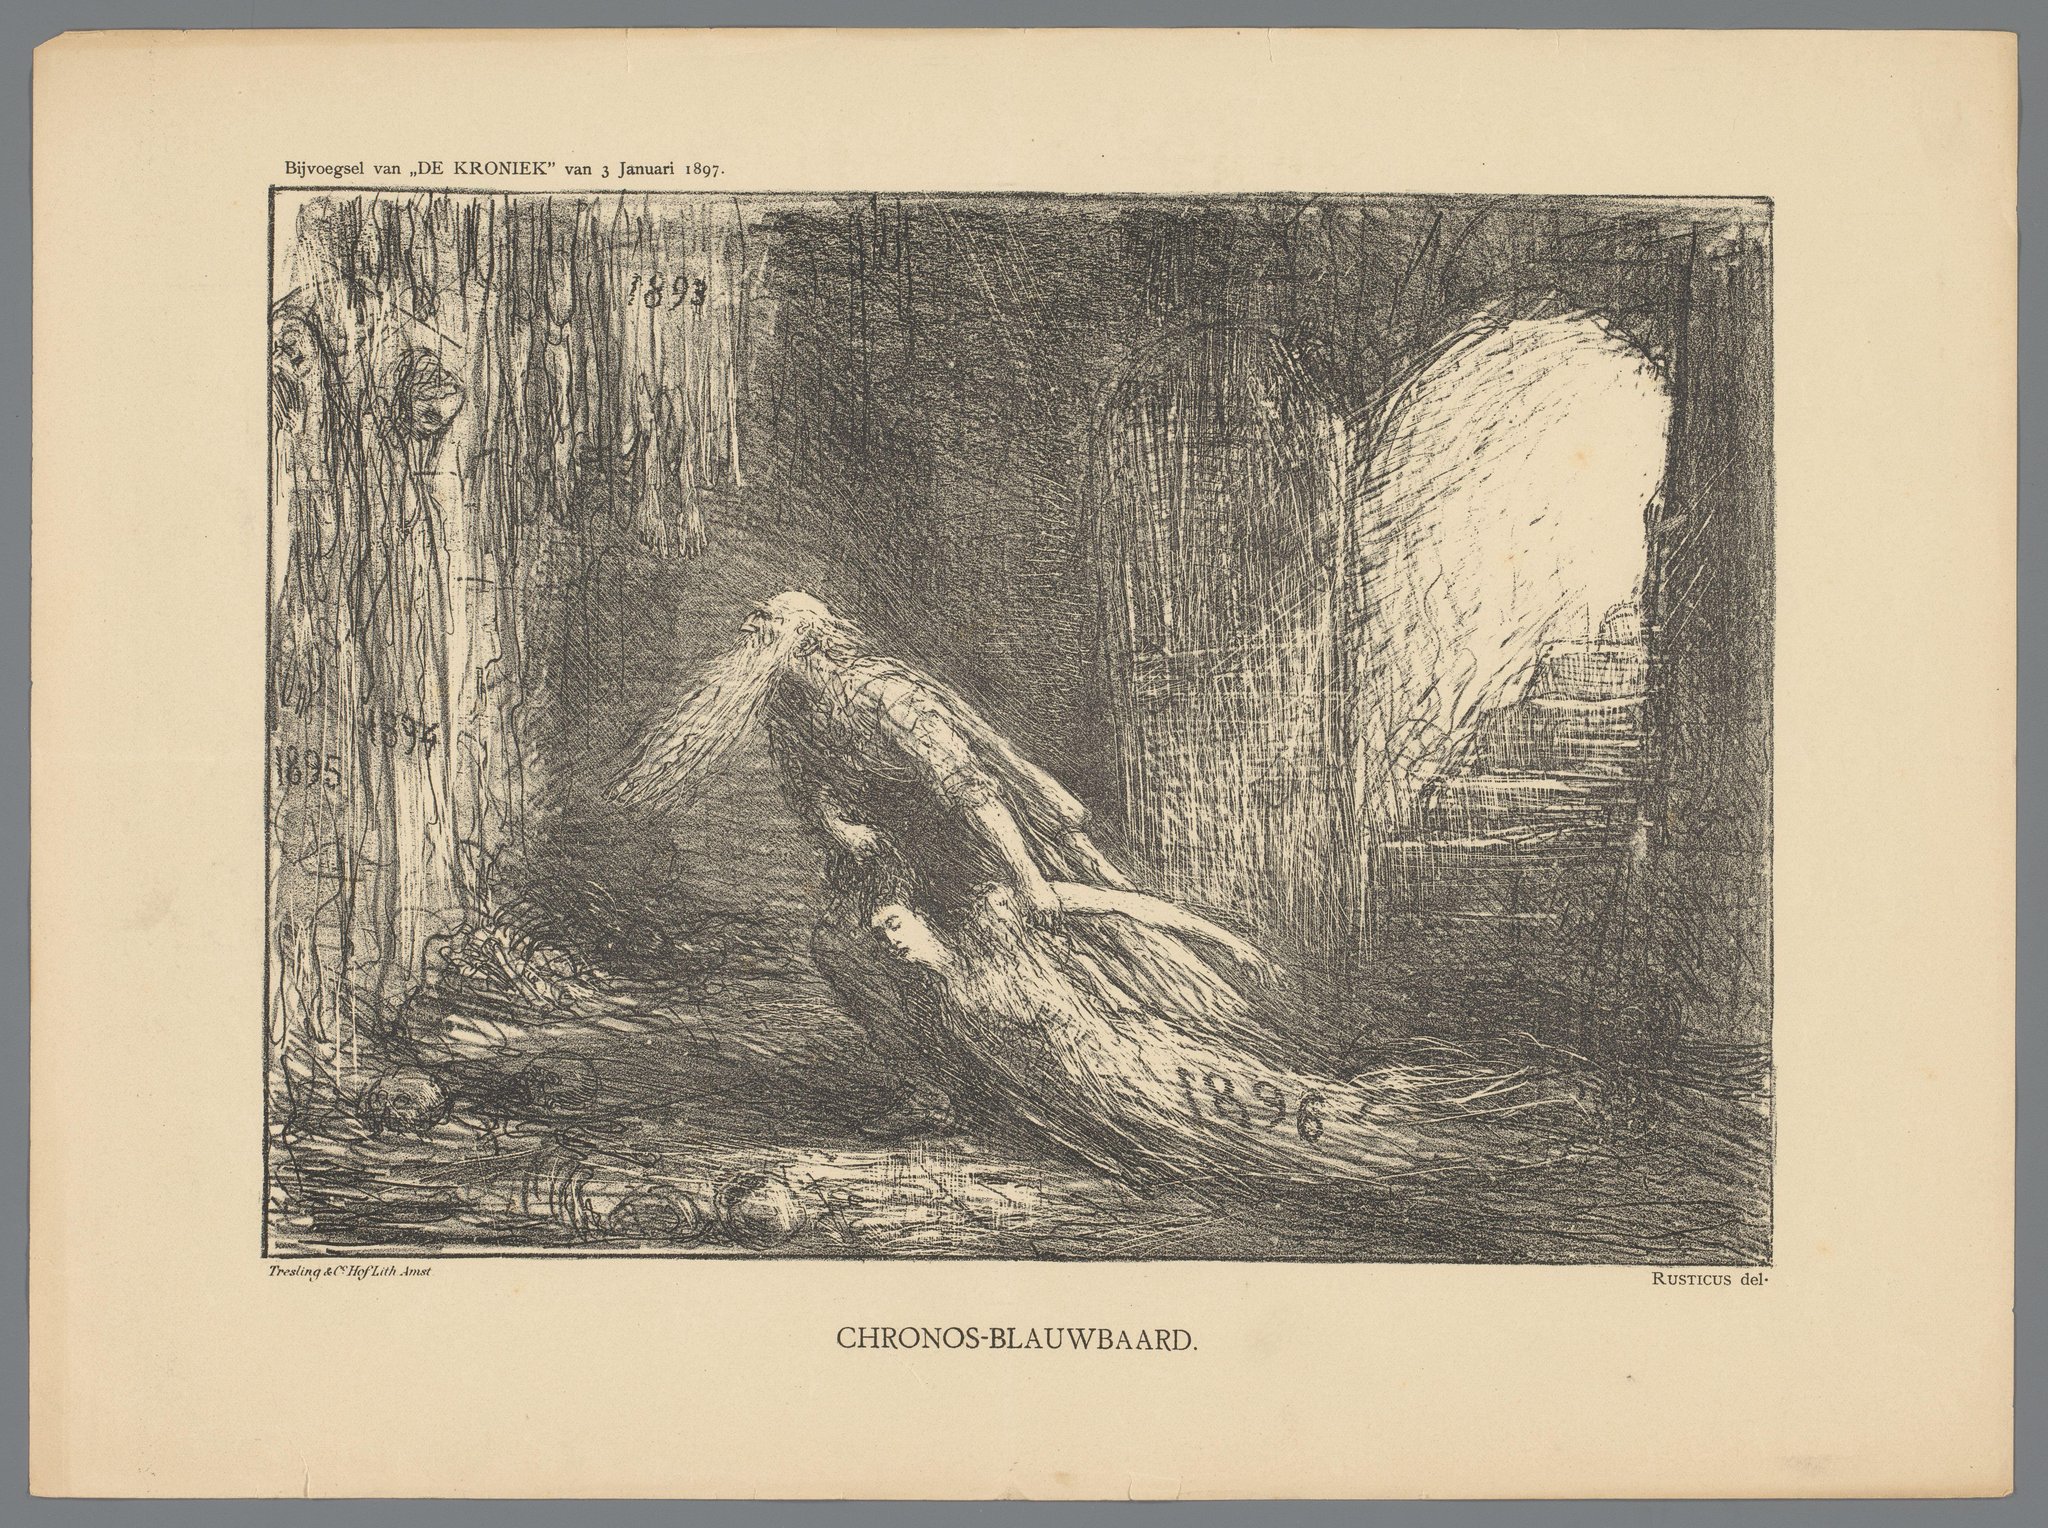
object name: print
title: Chronos-blauwbaard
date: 1897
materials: paper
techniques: lithograph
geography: amsterdam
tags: new year's eve (december 31)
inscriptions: date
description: Prent uit: De Kroniek. Een algemeen weekblad 3 (1897), nr. 1.